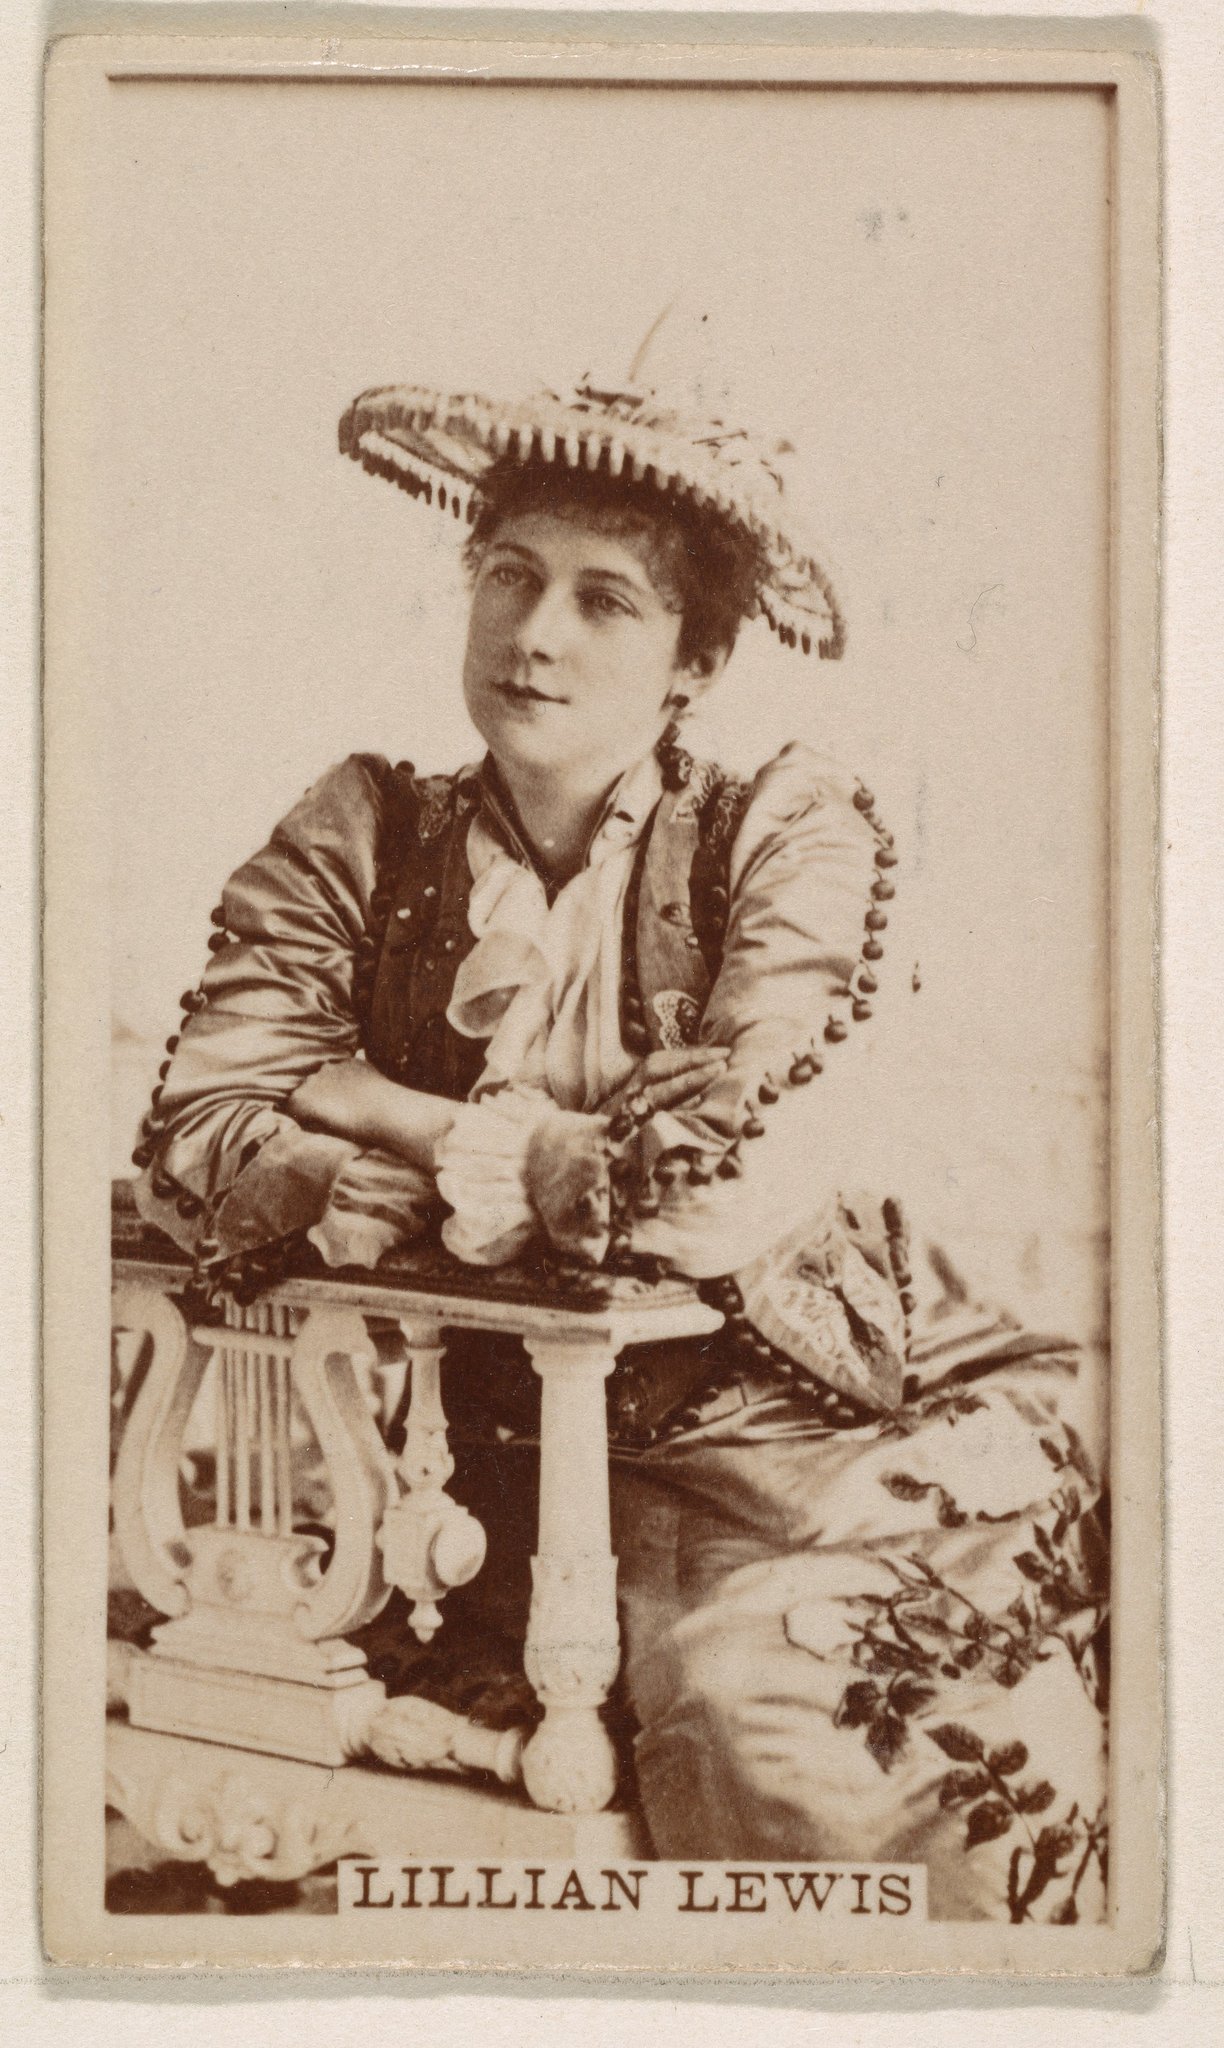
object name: photograph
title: Lillian Lewis, from the Actresses series (N245) issued by Kinney Brothers to promote Sweet Caporal Cigarettes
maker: kinney brothers tobacco company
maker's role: publisher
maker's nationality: american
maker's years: 1869-2011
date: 1890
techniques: albumen silver print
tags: portraits,women,actresses